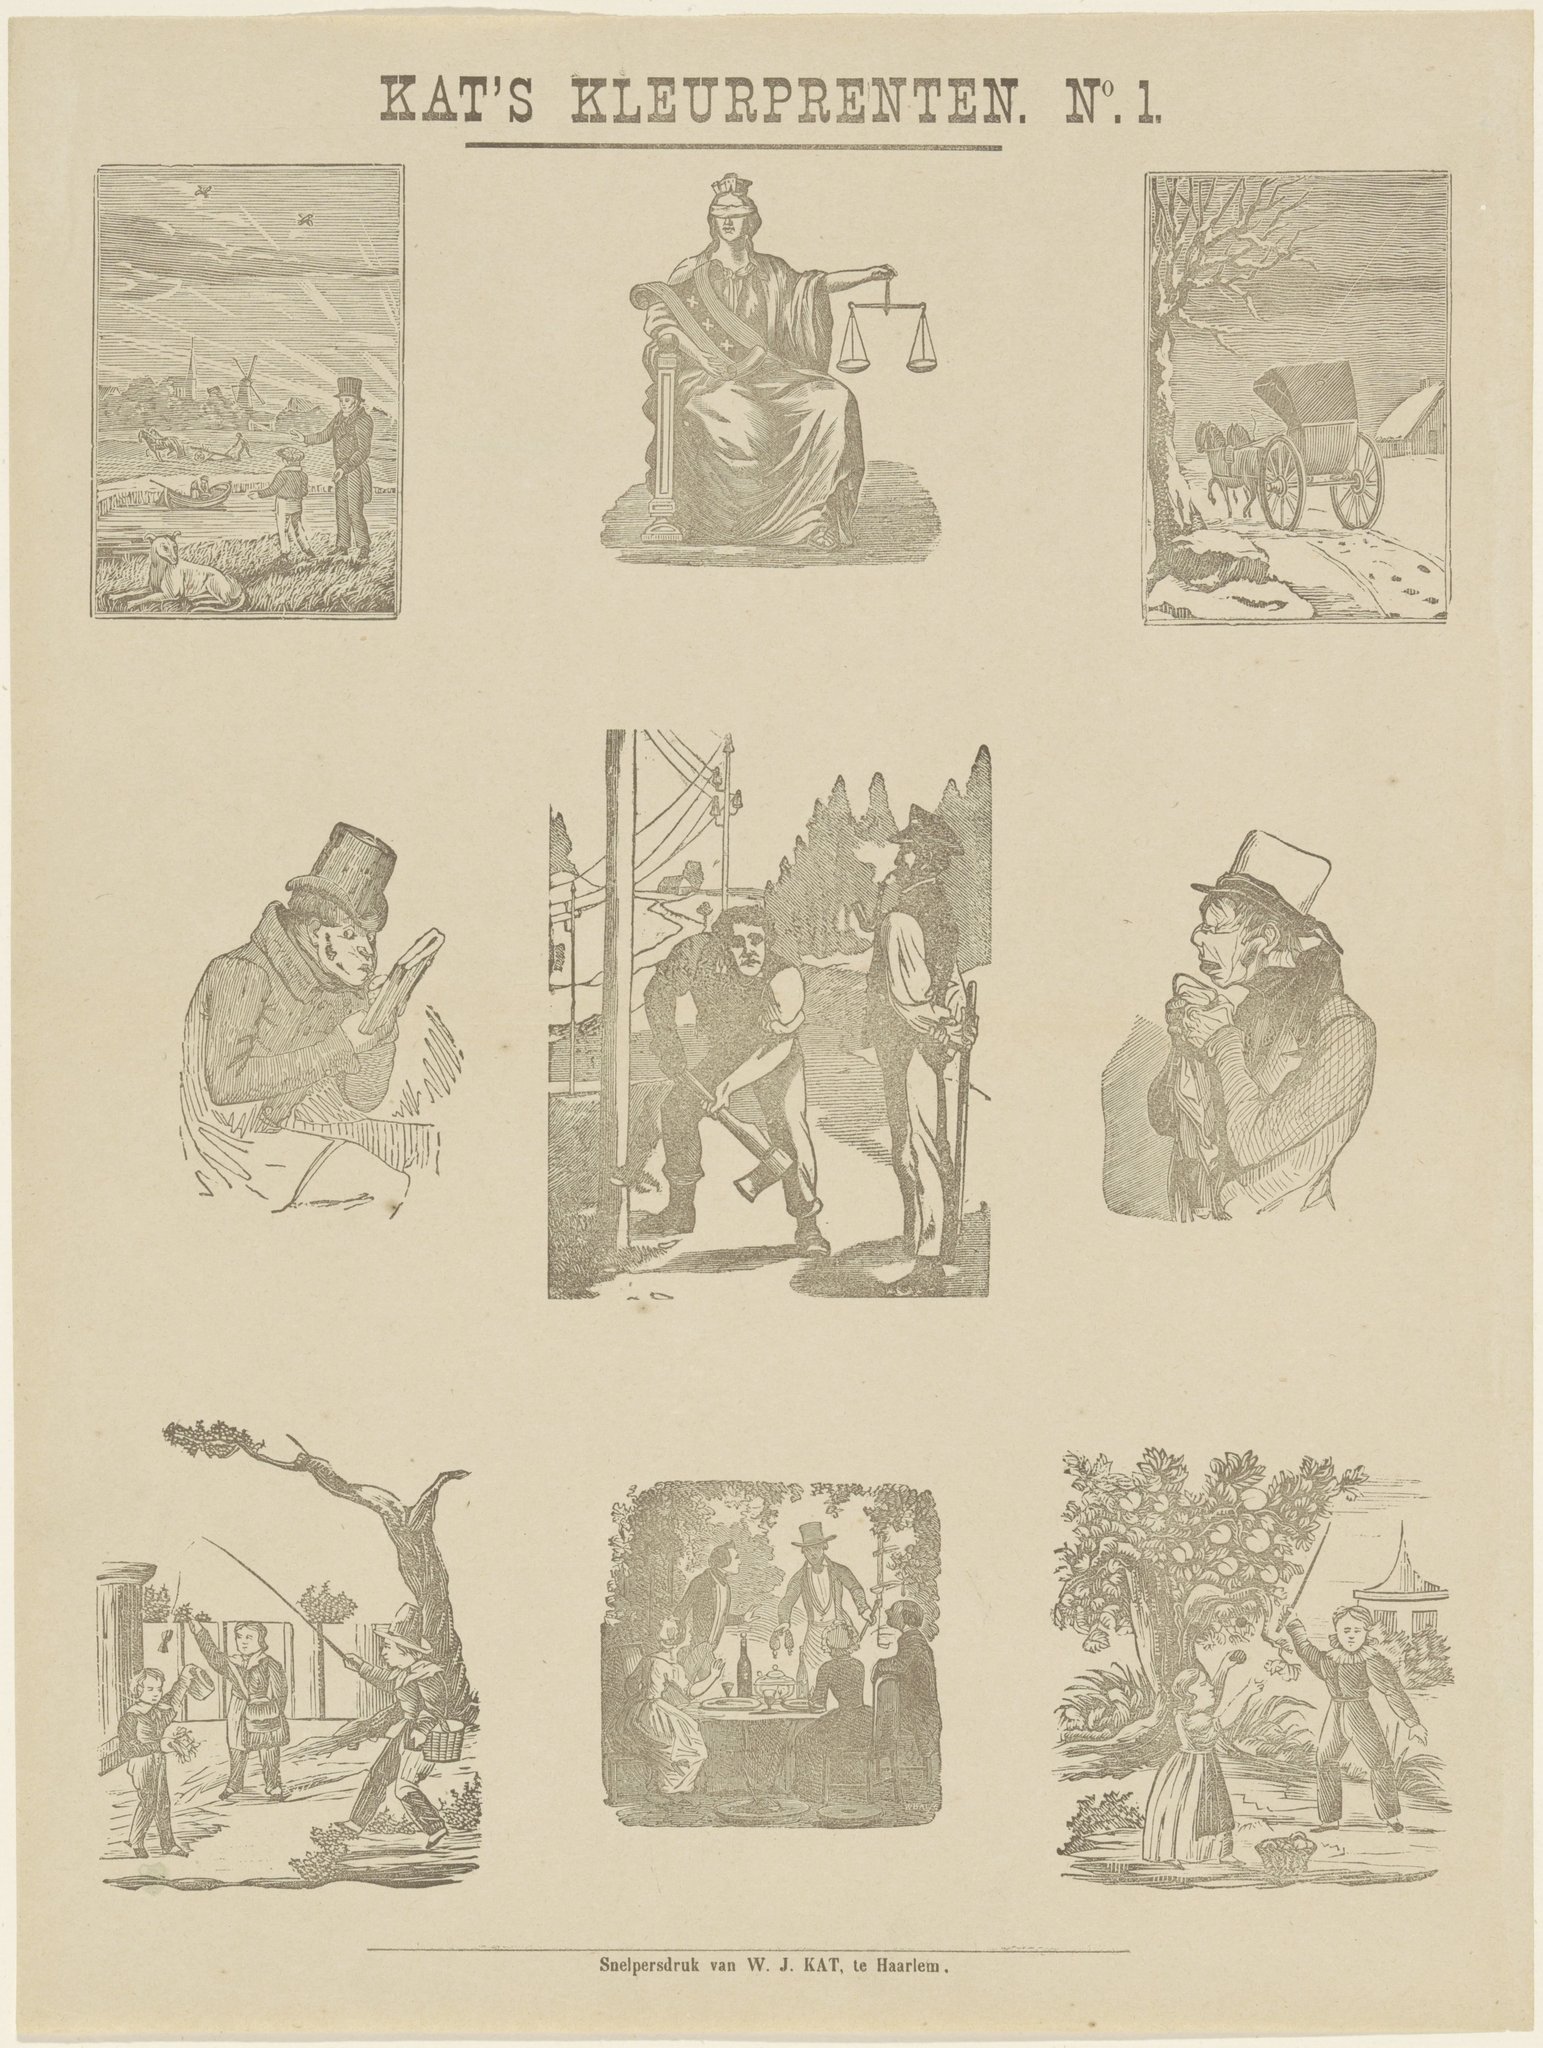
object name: print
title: Kat's kleurprenten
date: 1862-1882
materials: paper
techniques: engraving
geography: netherlands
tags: children's games and plays, caricatures (human types), justitia (justice) as roman personification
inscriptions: collector's mark: Lugt 2760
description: Blad met 9 afbeeldingen van verschillende onderwerpen, bedoeld om uit te knippen en in te kleuren. Weergegeven zijn onder meer justitia, karikaturen en spelende kinderen. Genummerd rechtsboven: No. 1.